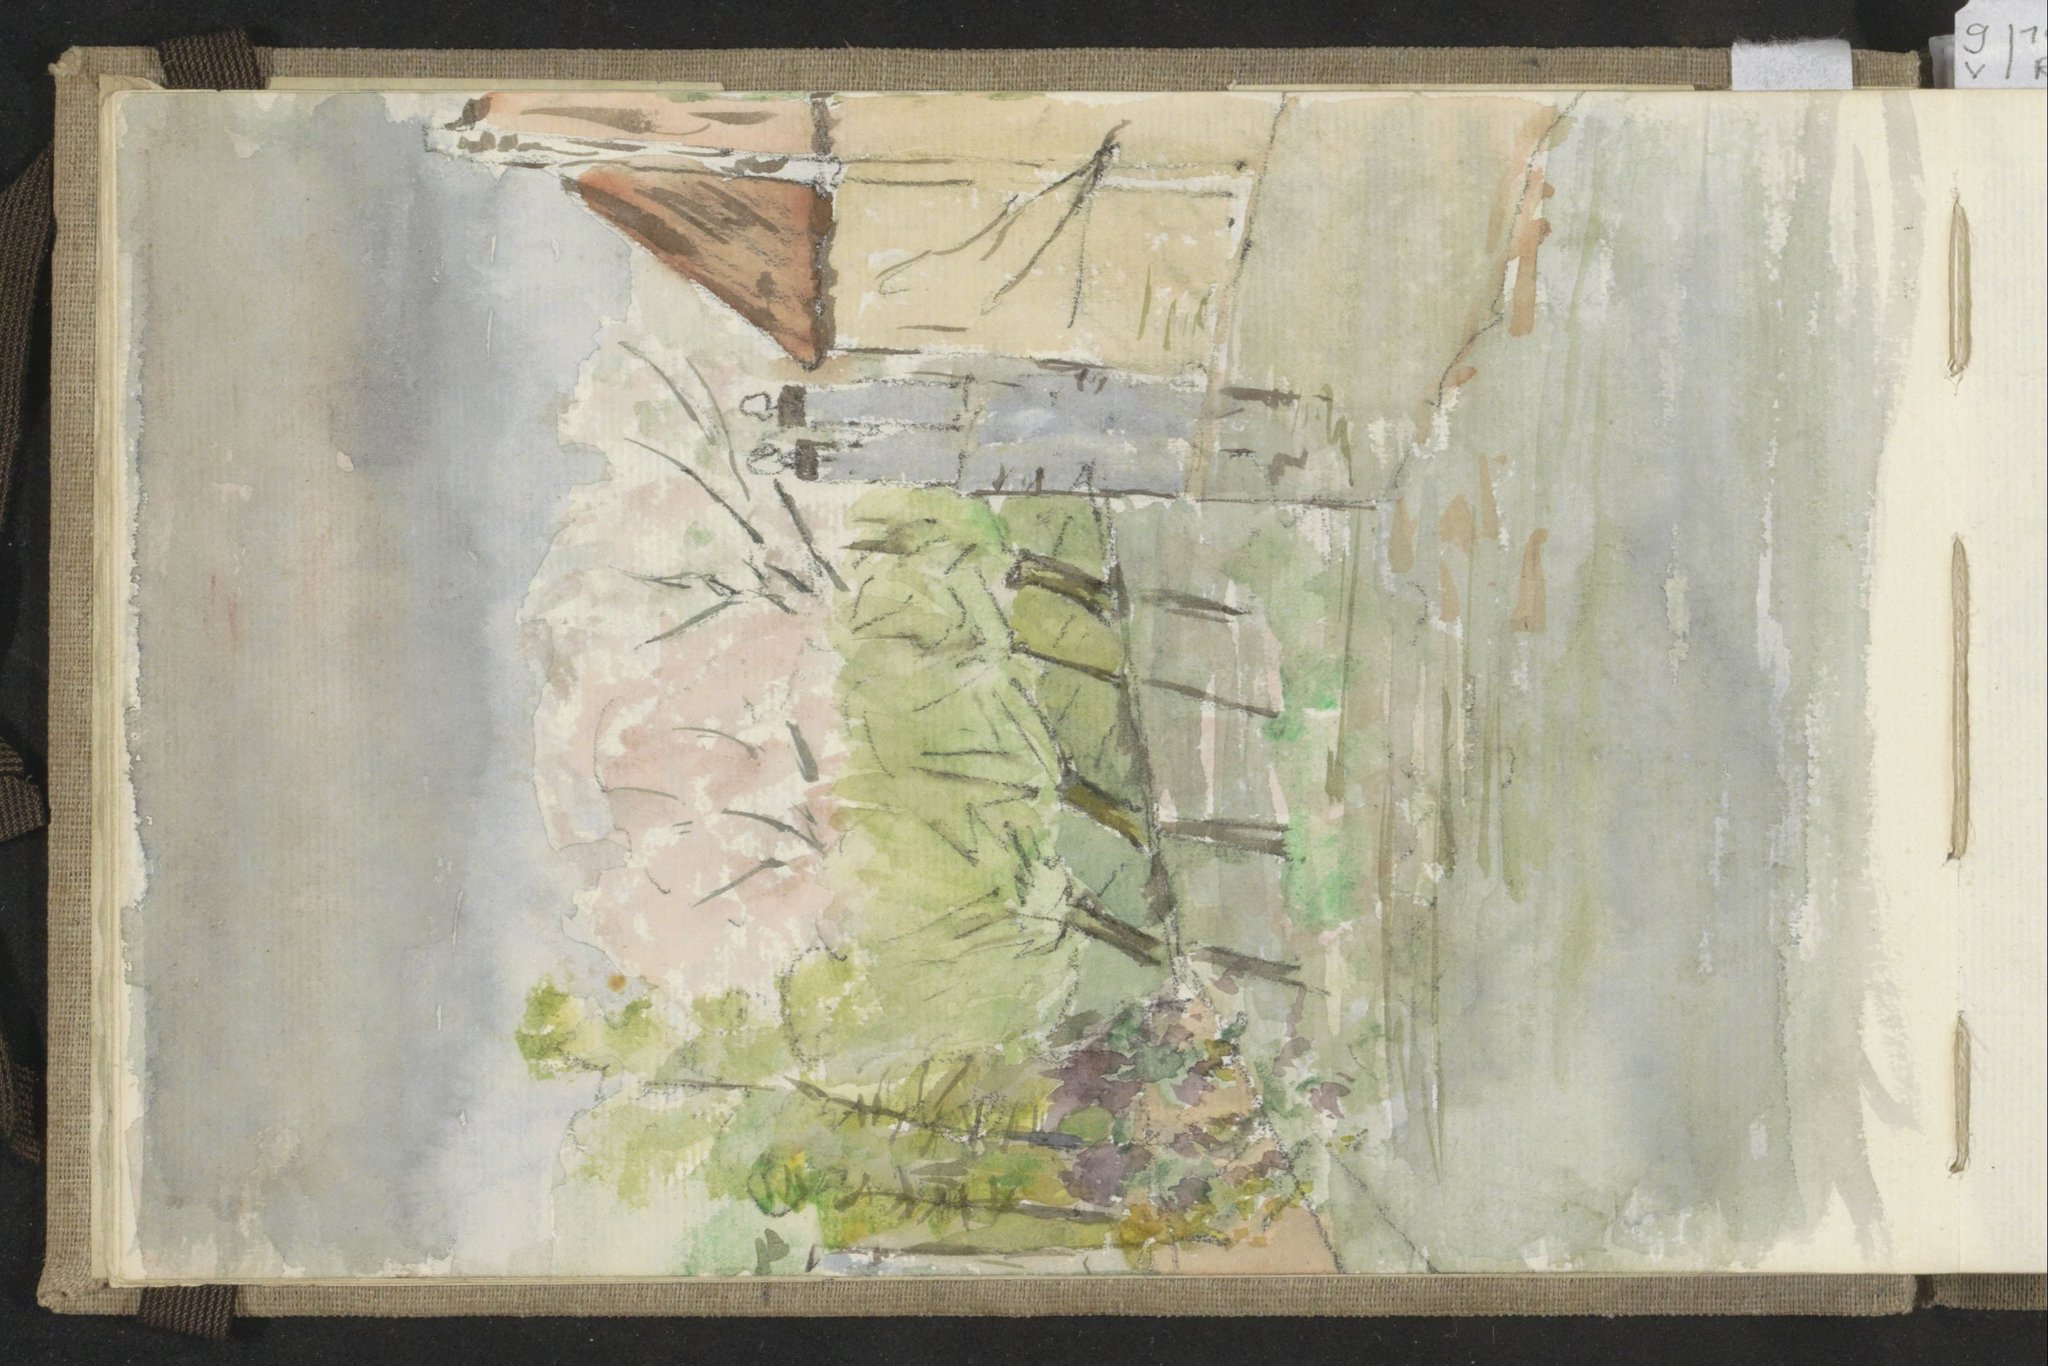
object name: sketchbook leaf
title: Bomen aan een waterkant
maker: jonkheer johannes ludovicus paulus bosch van drakestein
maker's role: draughtsman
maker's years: 1865-1929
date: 1896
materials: paper, pencil, watercolor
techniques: brush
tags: trees, landscapes with waters, waterscapes, seascapes (in the temperate zone), the usual house or row of houses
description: Aan de overkant van het water staat een gebouw met een schoorsteen. Blad 6 verso uit een schetsboek met 58 bladen.